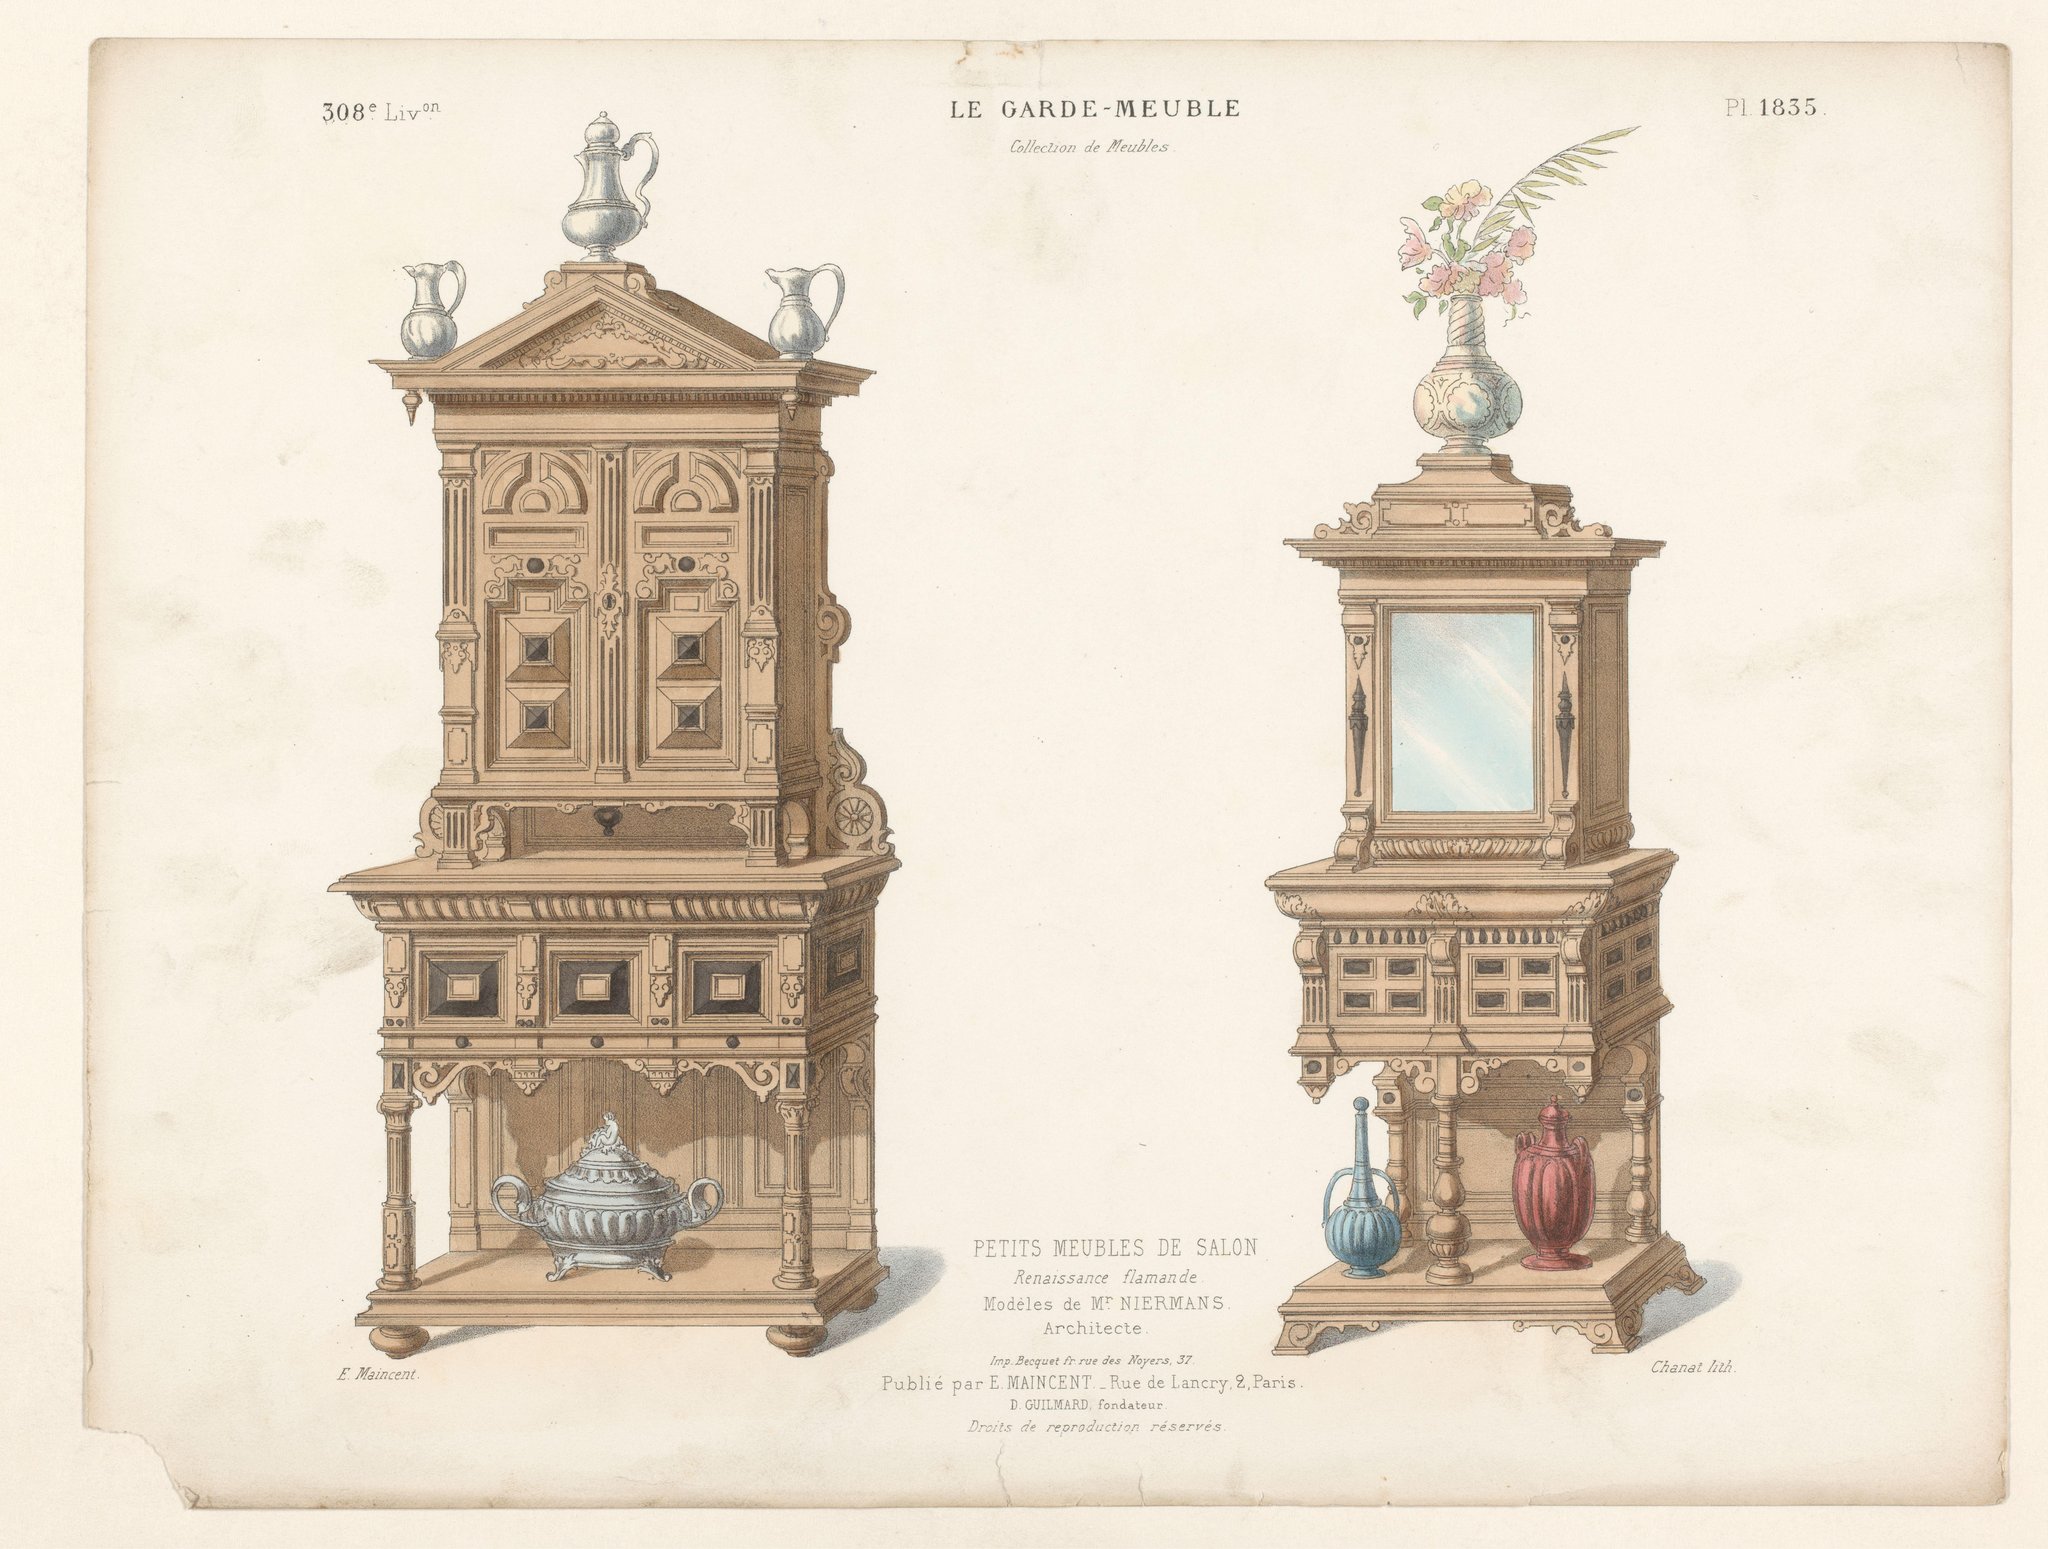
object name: print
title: Petit meubles de salon Renaissance flamance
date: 1885-1895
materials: paper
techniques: hand coloring, lithograph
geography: paris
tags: furniture for storage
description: Ieder Livraison in de serie Le Garde-Meuble bevat negen platen: drie 'sièges' (zitmeubels), drie 'meubles' (diverse meubels zoals tafels en kasten) en drie 'tentures' (gordijnen en draperieën).